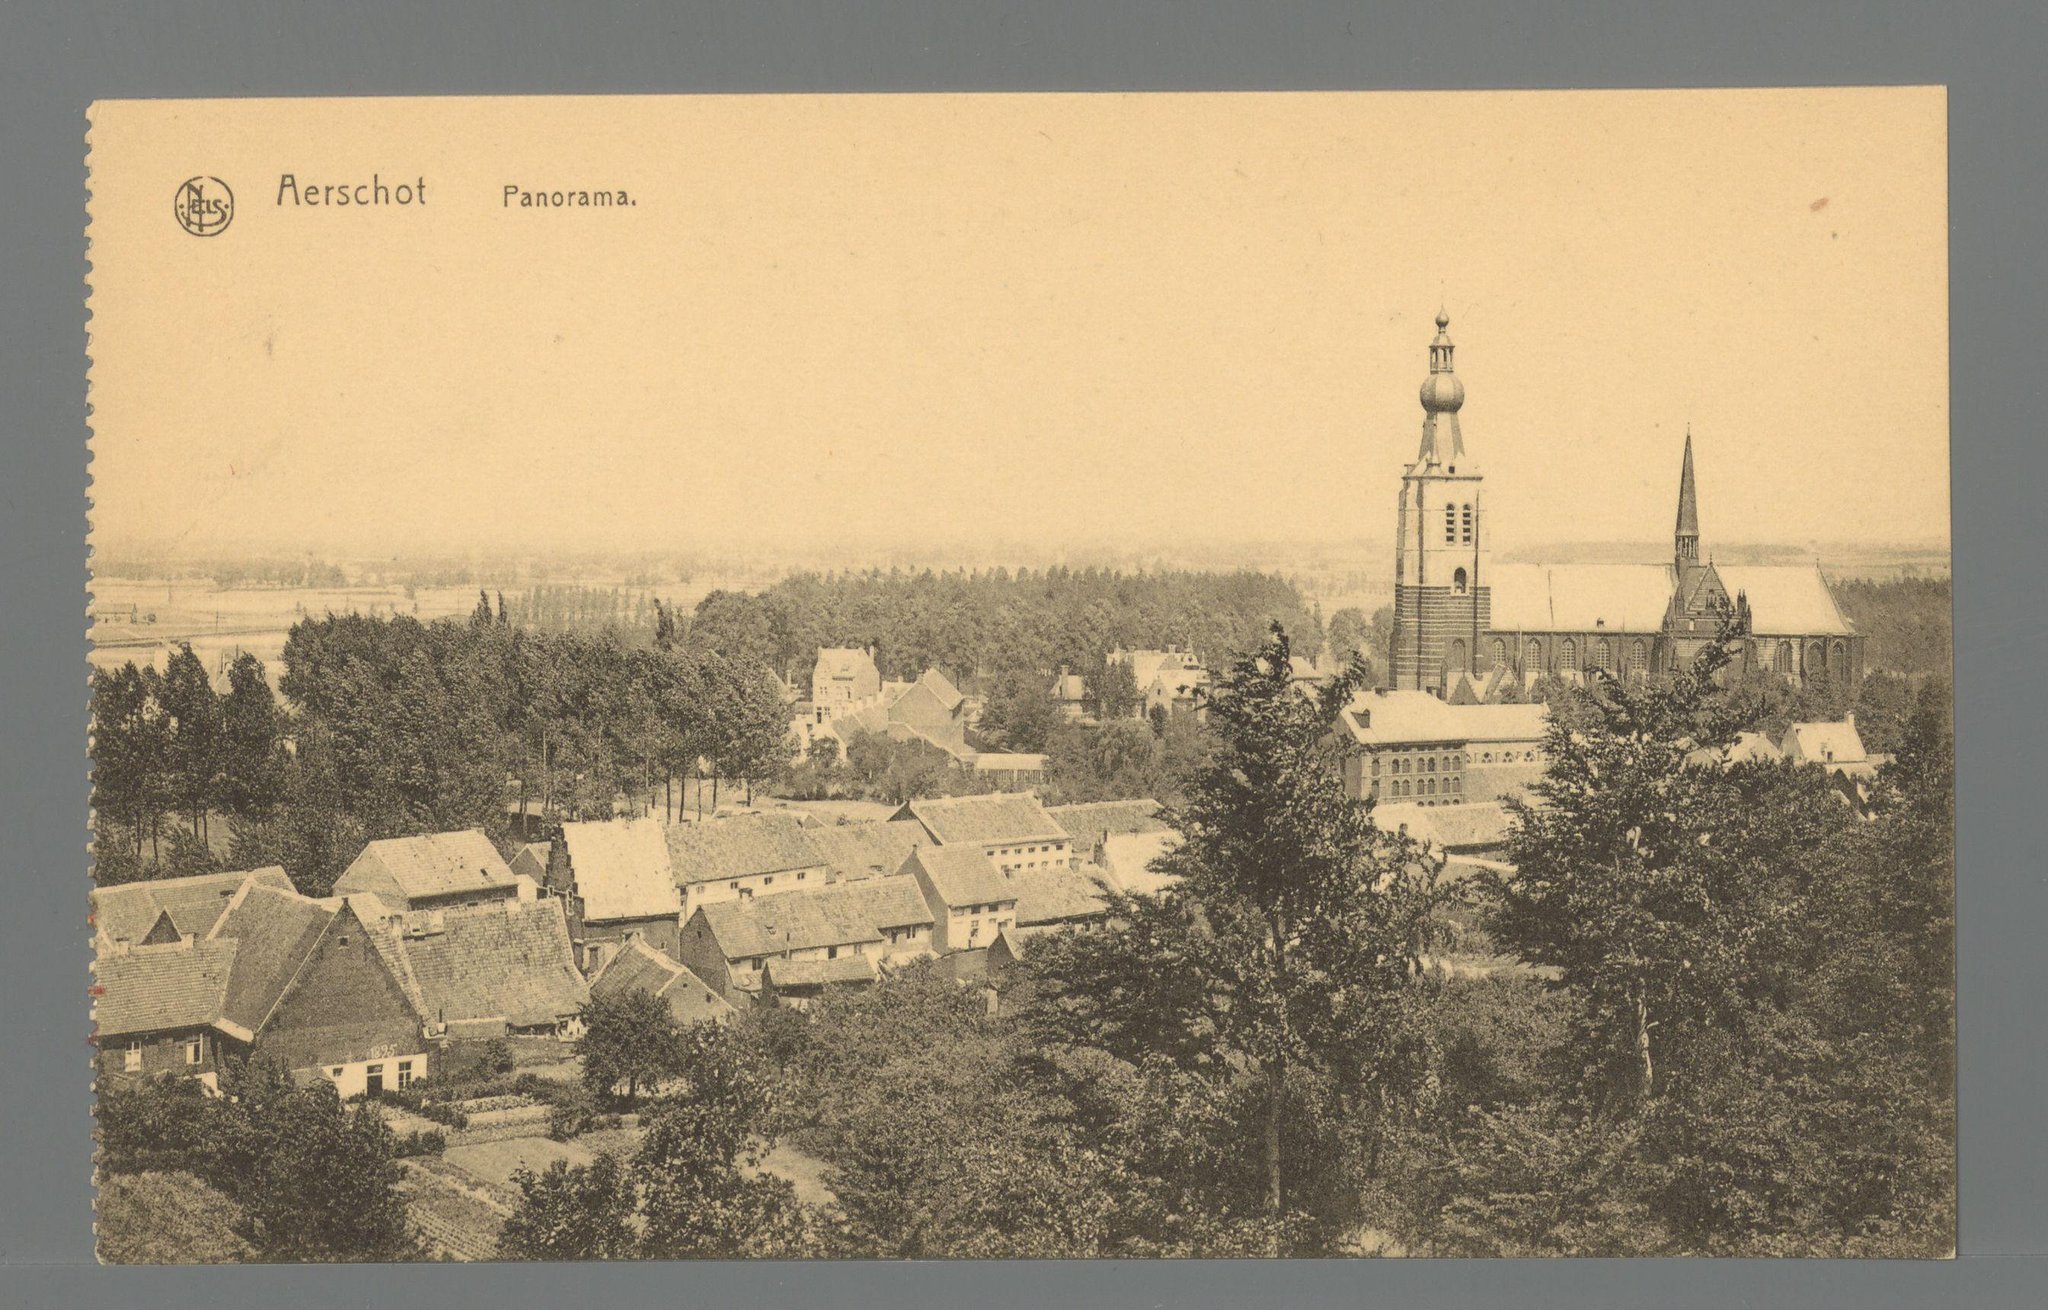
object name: photomechanical print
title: Aerschot. Panorama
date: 1913-1930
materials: cardboard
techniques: photograph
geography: brussels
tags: church (exterior), prospect of city, town panorama, silhouette of city